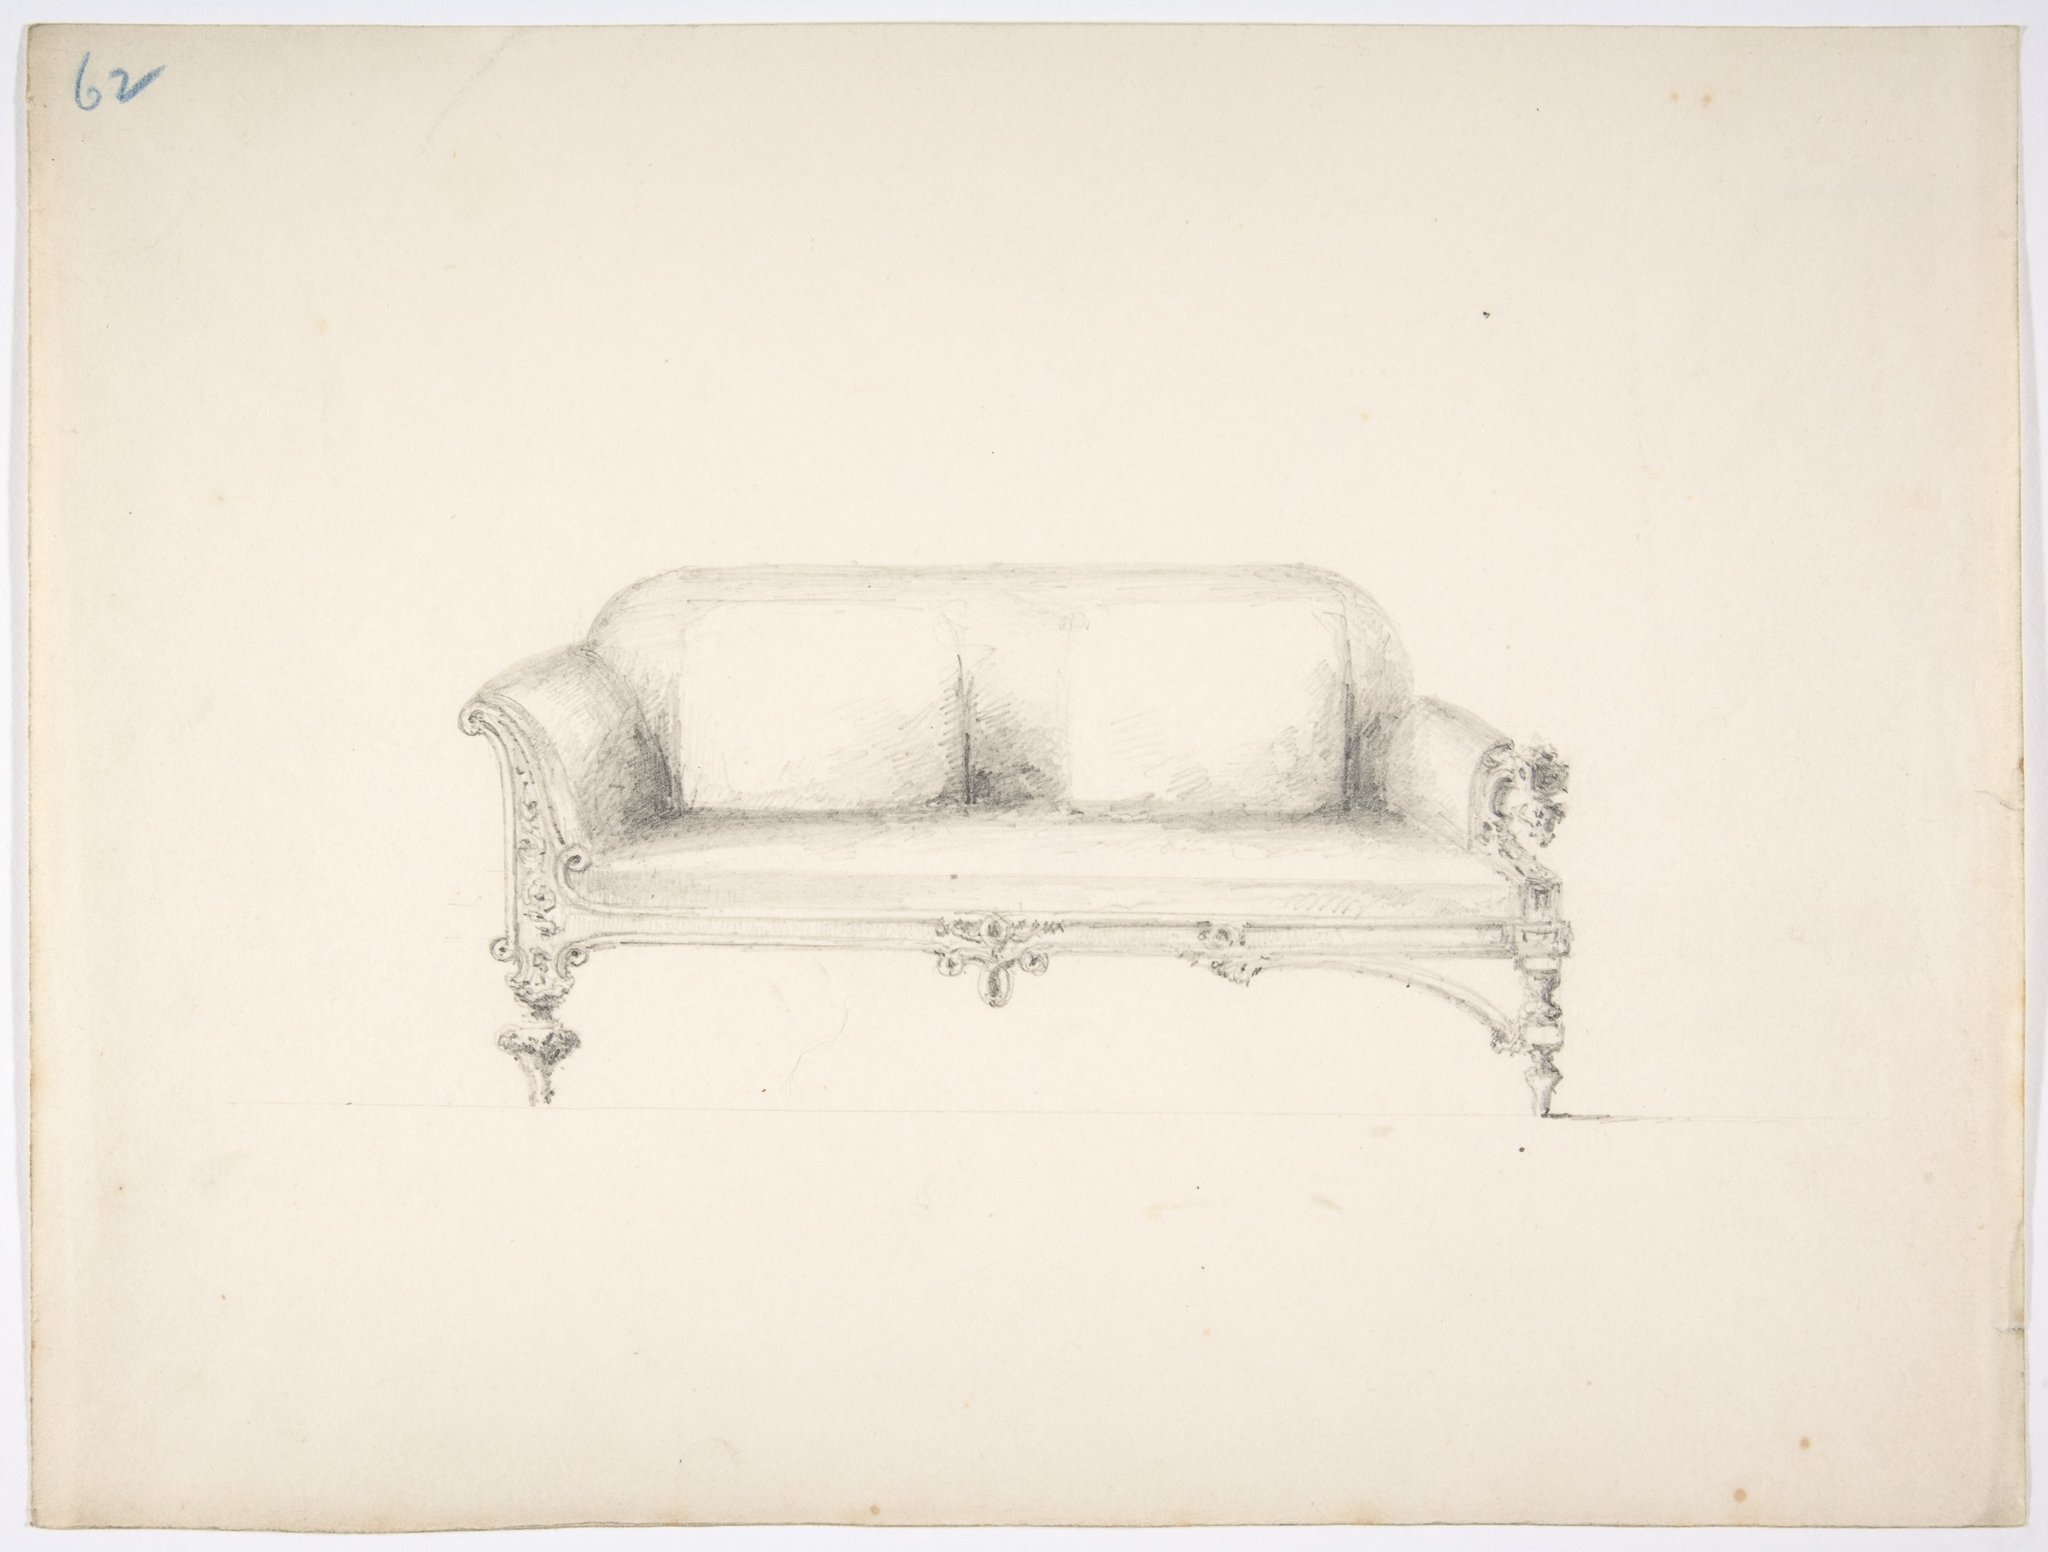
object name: drawing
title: Design for a Sofa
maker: anonymous, british, 19th century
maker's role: artist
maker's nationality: british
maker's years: 1800-1900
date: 1801-1833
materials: graphite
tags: couches